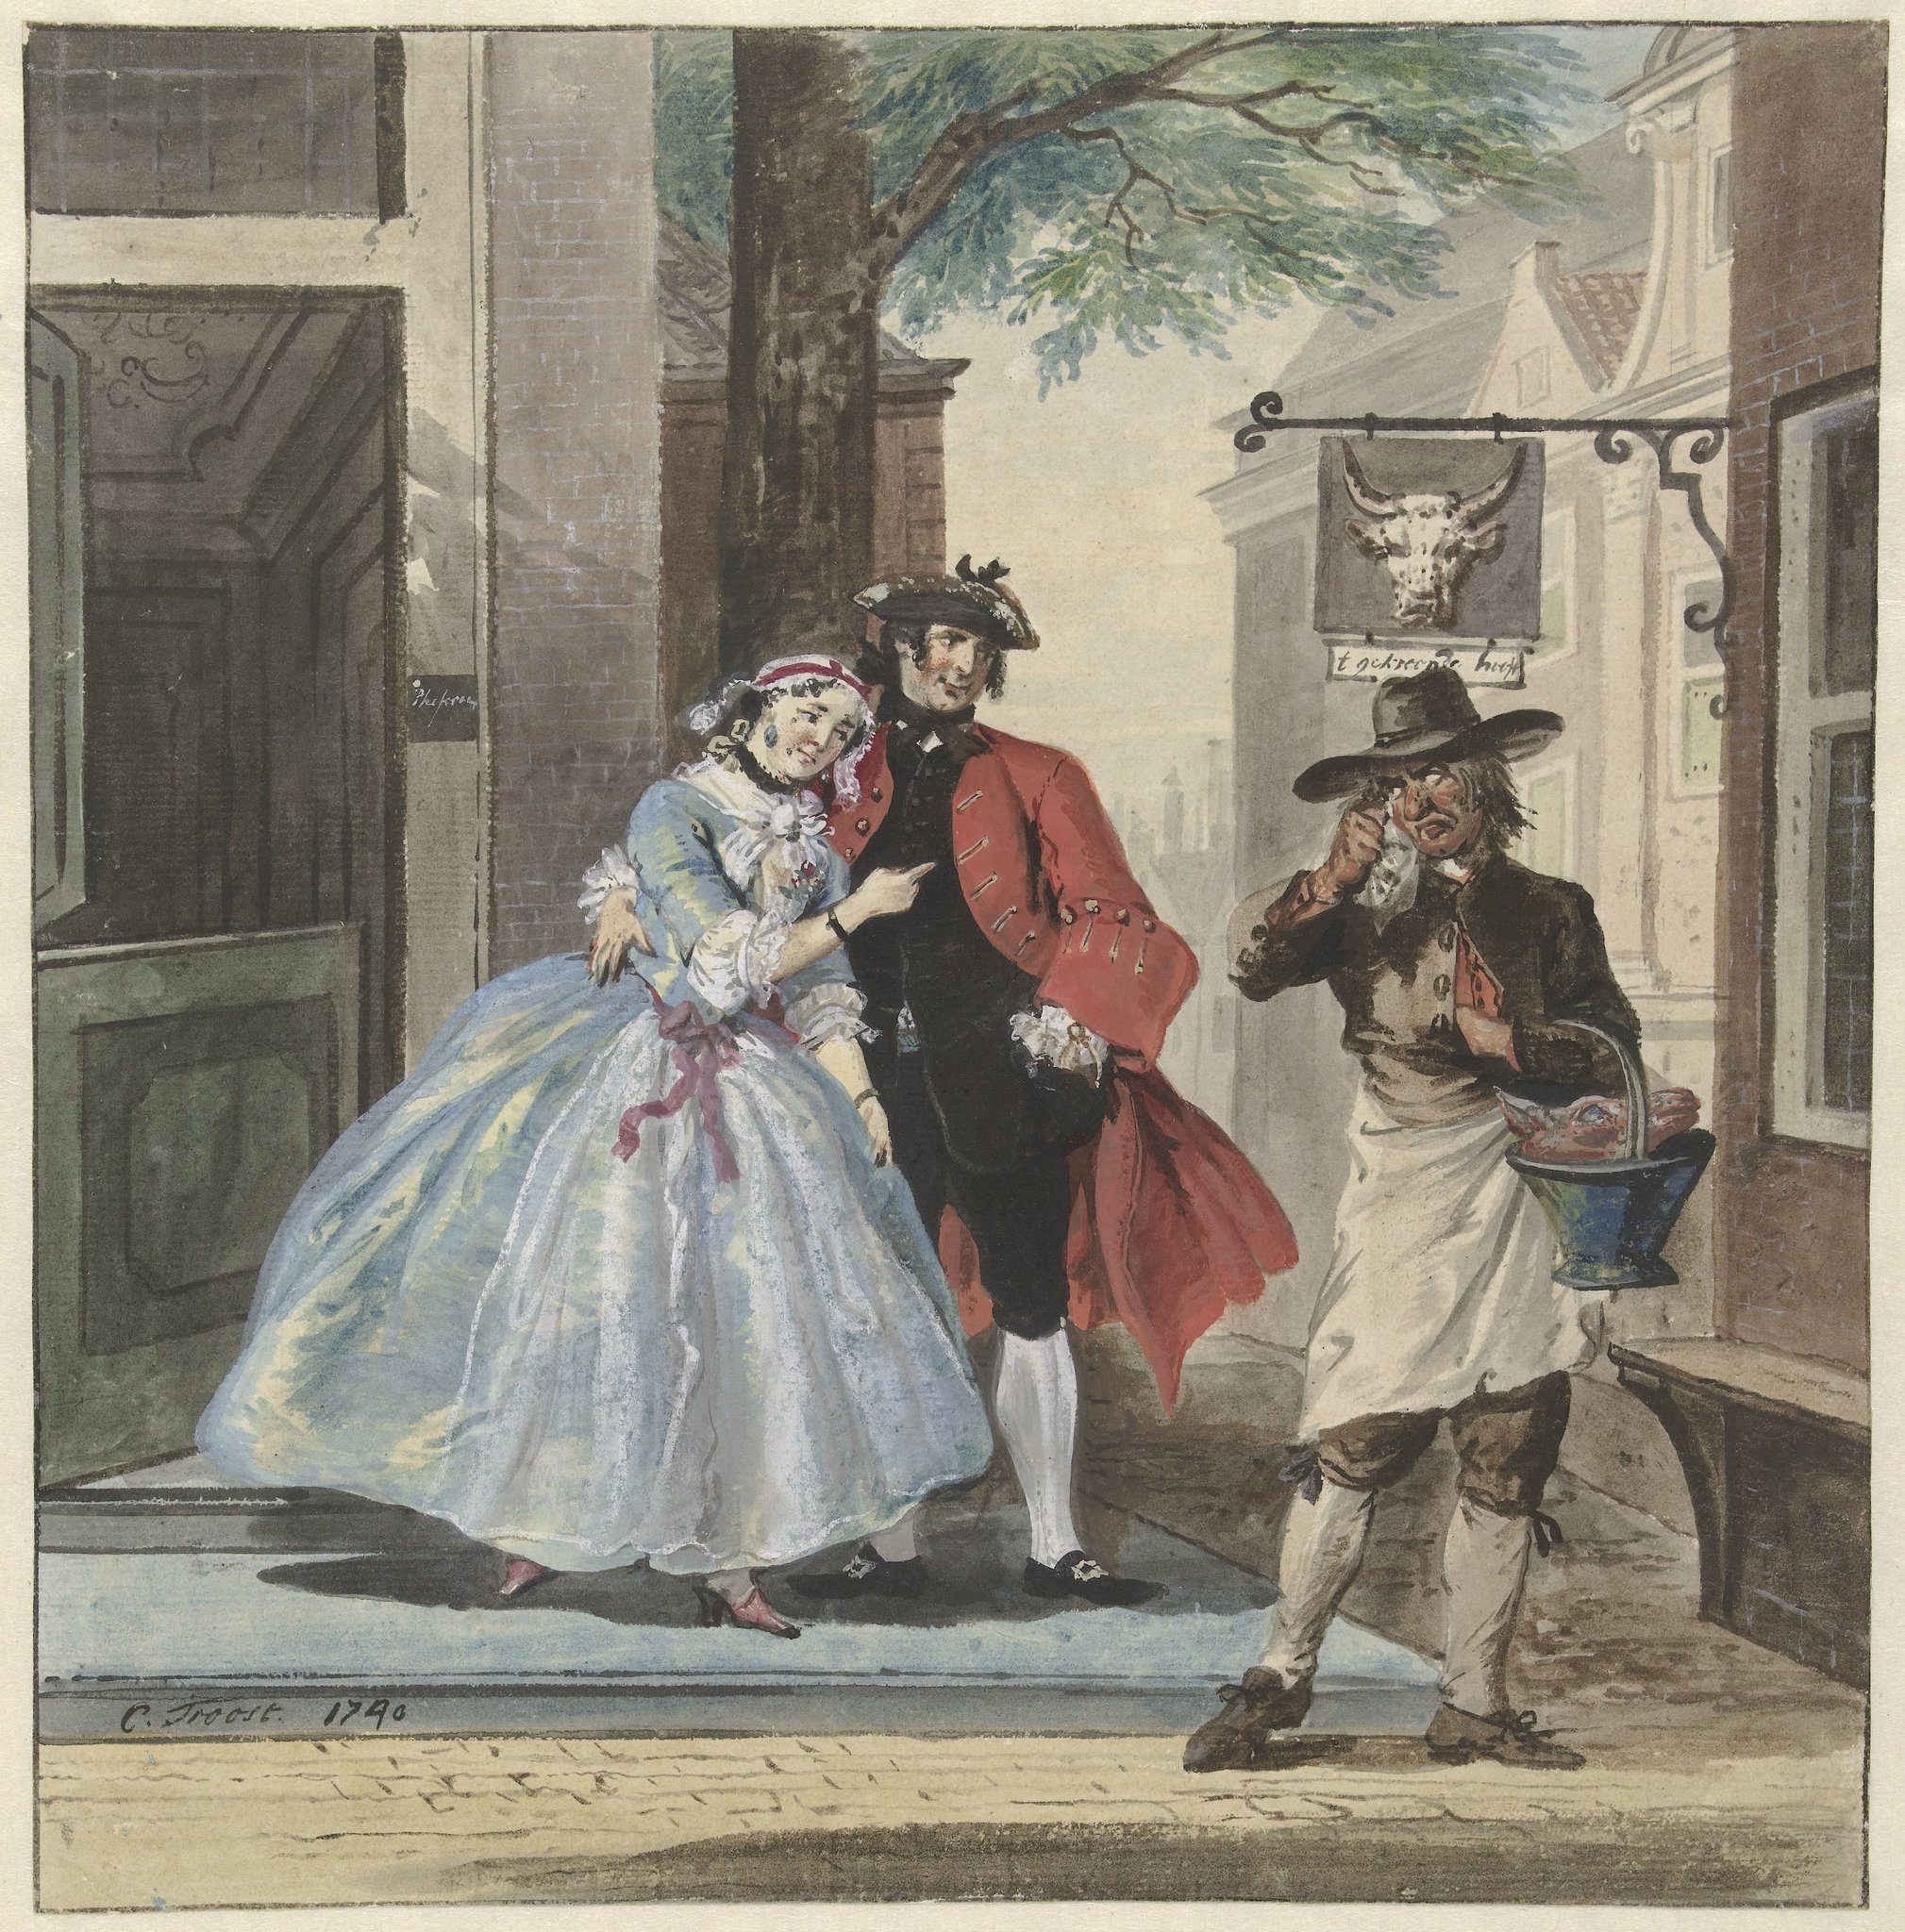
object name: drawing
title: Toneelscène uit Pefroen met het schaapshoofd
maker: cornelis troost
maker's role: draughtsman, painter, print maker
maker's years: 1696-1750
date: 1740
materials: paint, paper, watercolor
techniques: brush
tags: signboard, couple of lovers, comedy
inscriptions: date